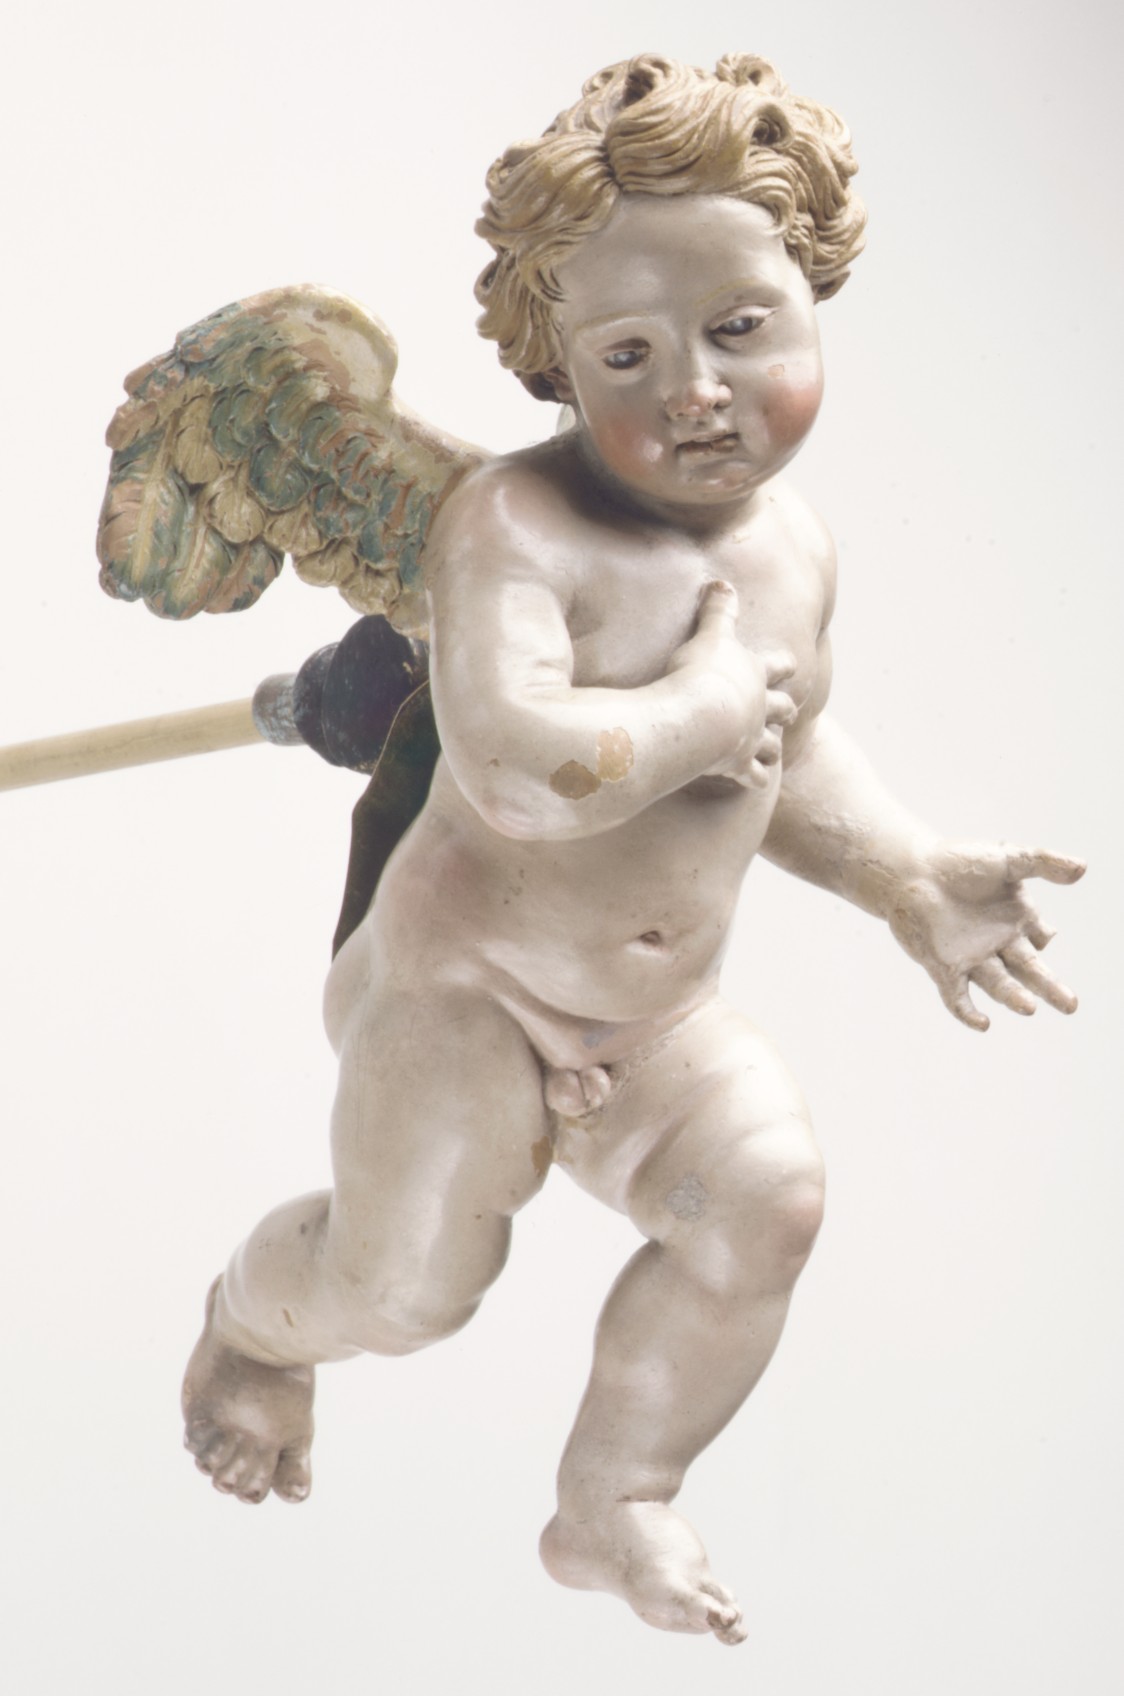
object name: crèche figure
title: Cherub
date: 1751-1800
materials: terracotta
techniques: polychrome